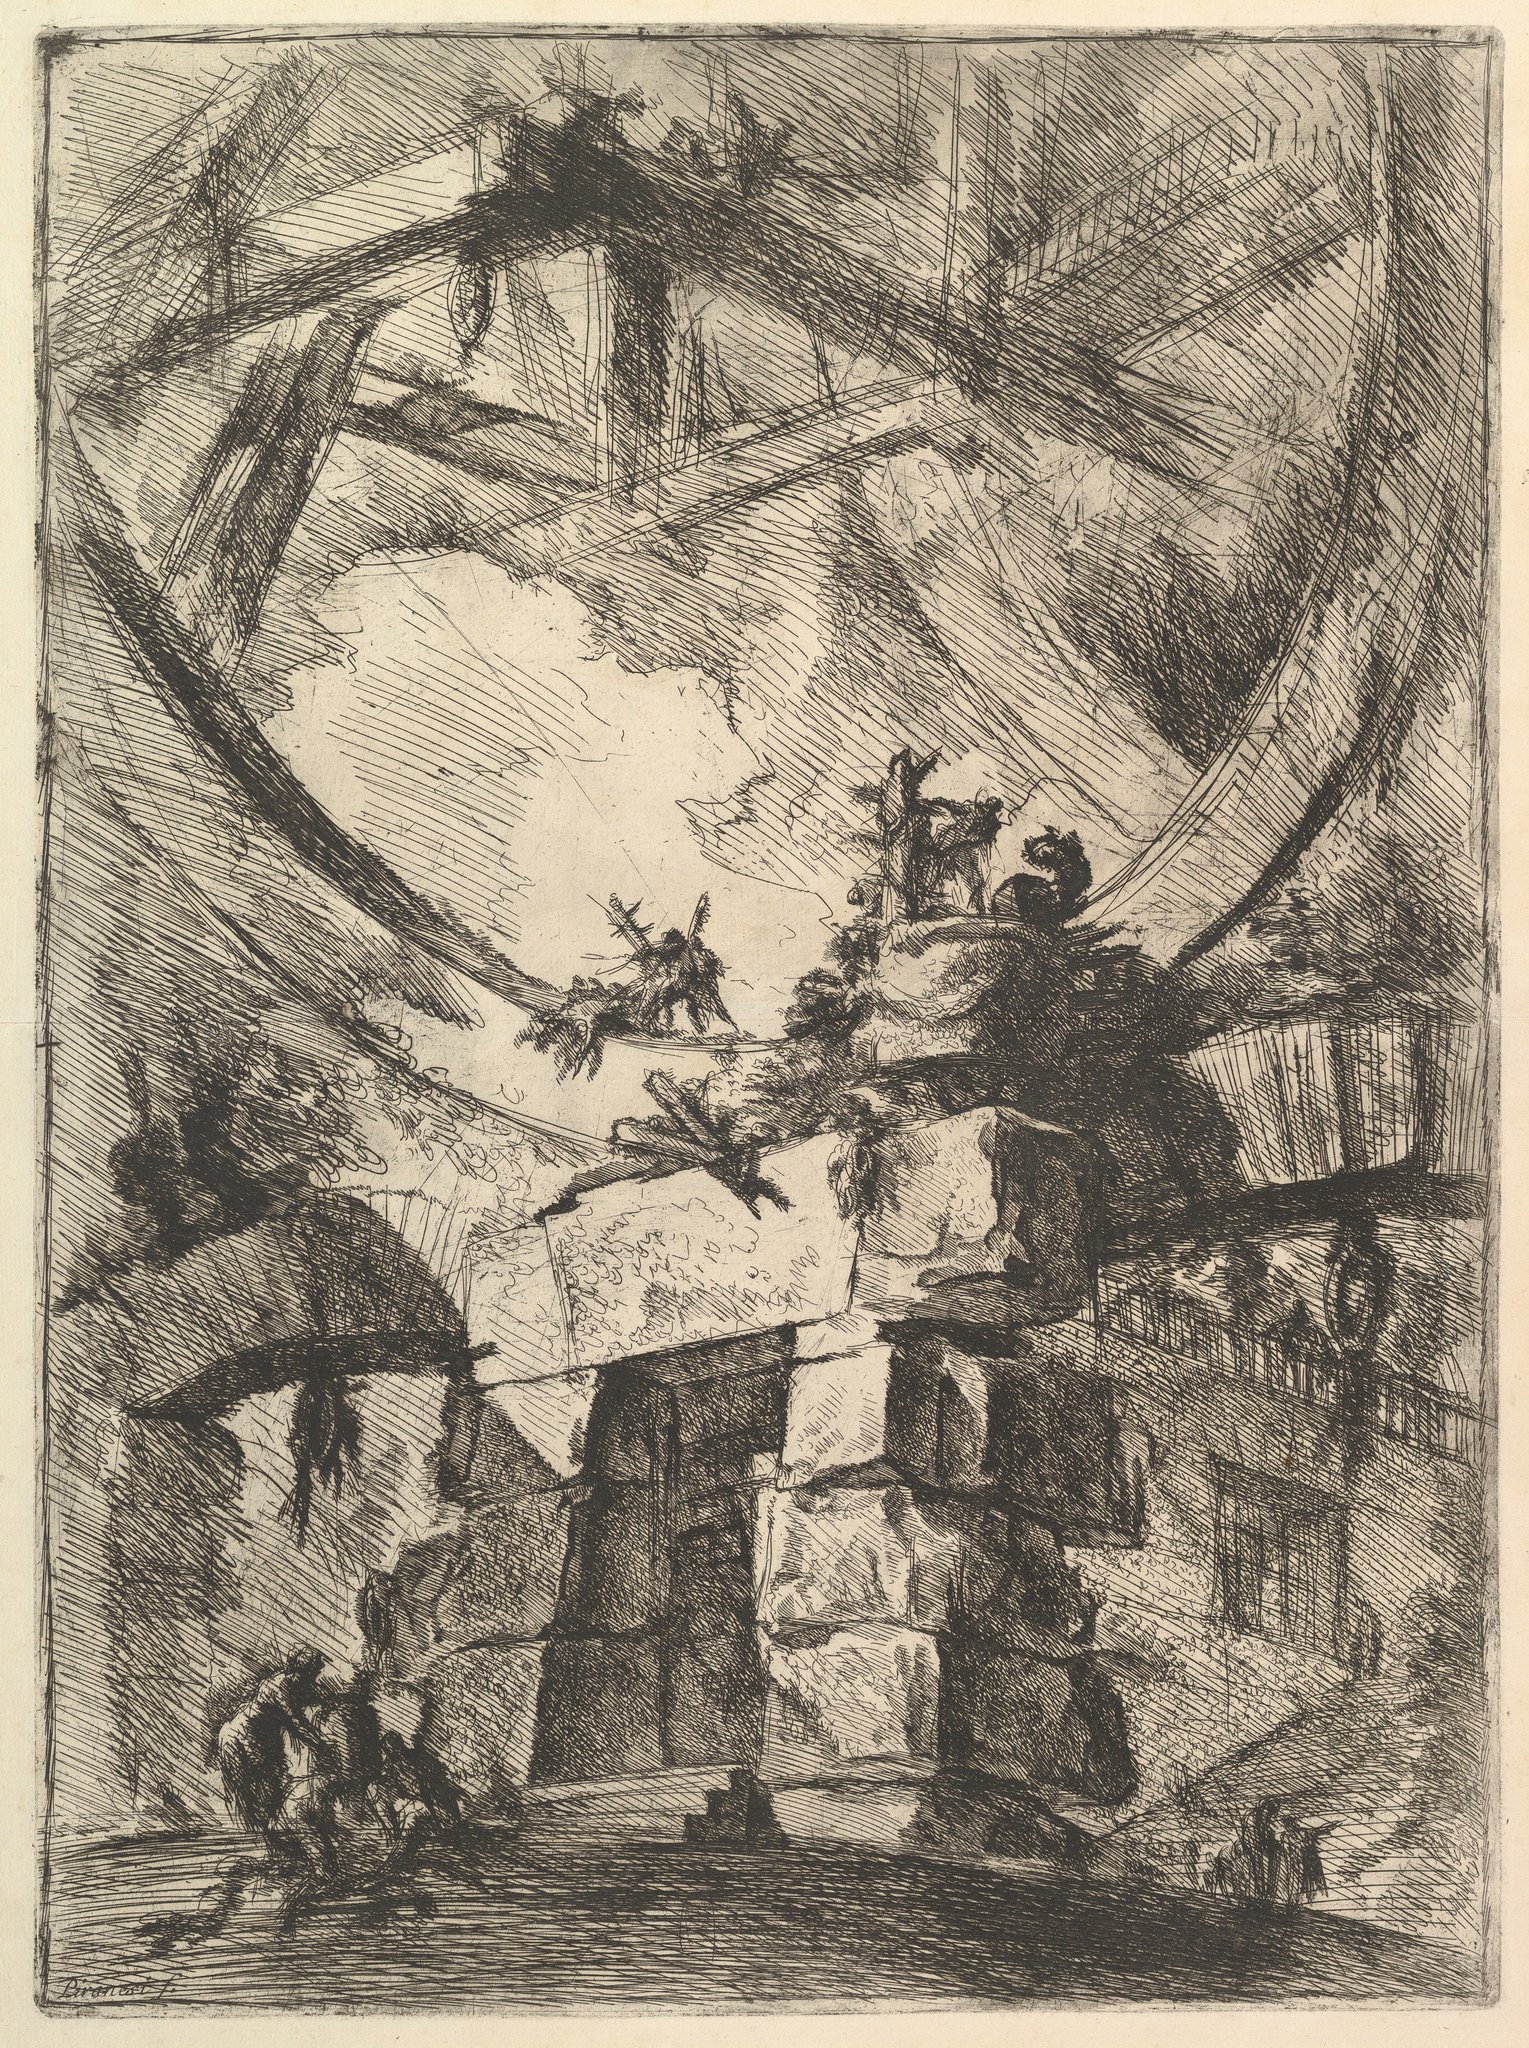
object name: print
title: The Giant Wheel, from "Carceri d'invenzione" (Imaginary Prisons)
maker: giovanni battista piranesi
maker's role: artist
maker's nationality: italian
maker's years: 1720-1778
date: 1749-1750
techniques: engraving, etching